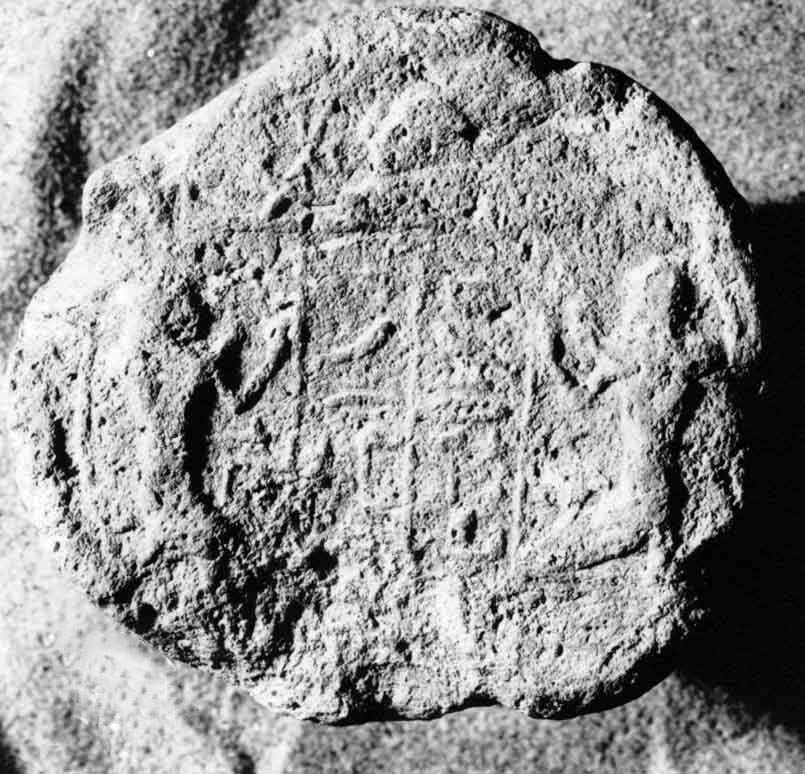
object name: cone, padihorresnet, round stamp, chief steward, divine adoratrice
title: Funerary Cone of the Chief Steward Padihorresnet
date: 1550-1295 BCE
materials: pottery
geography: egypt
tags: hieroglyphs